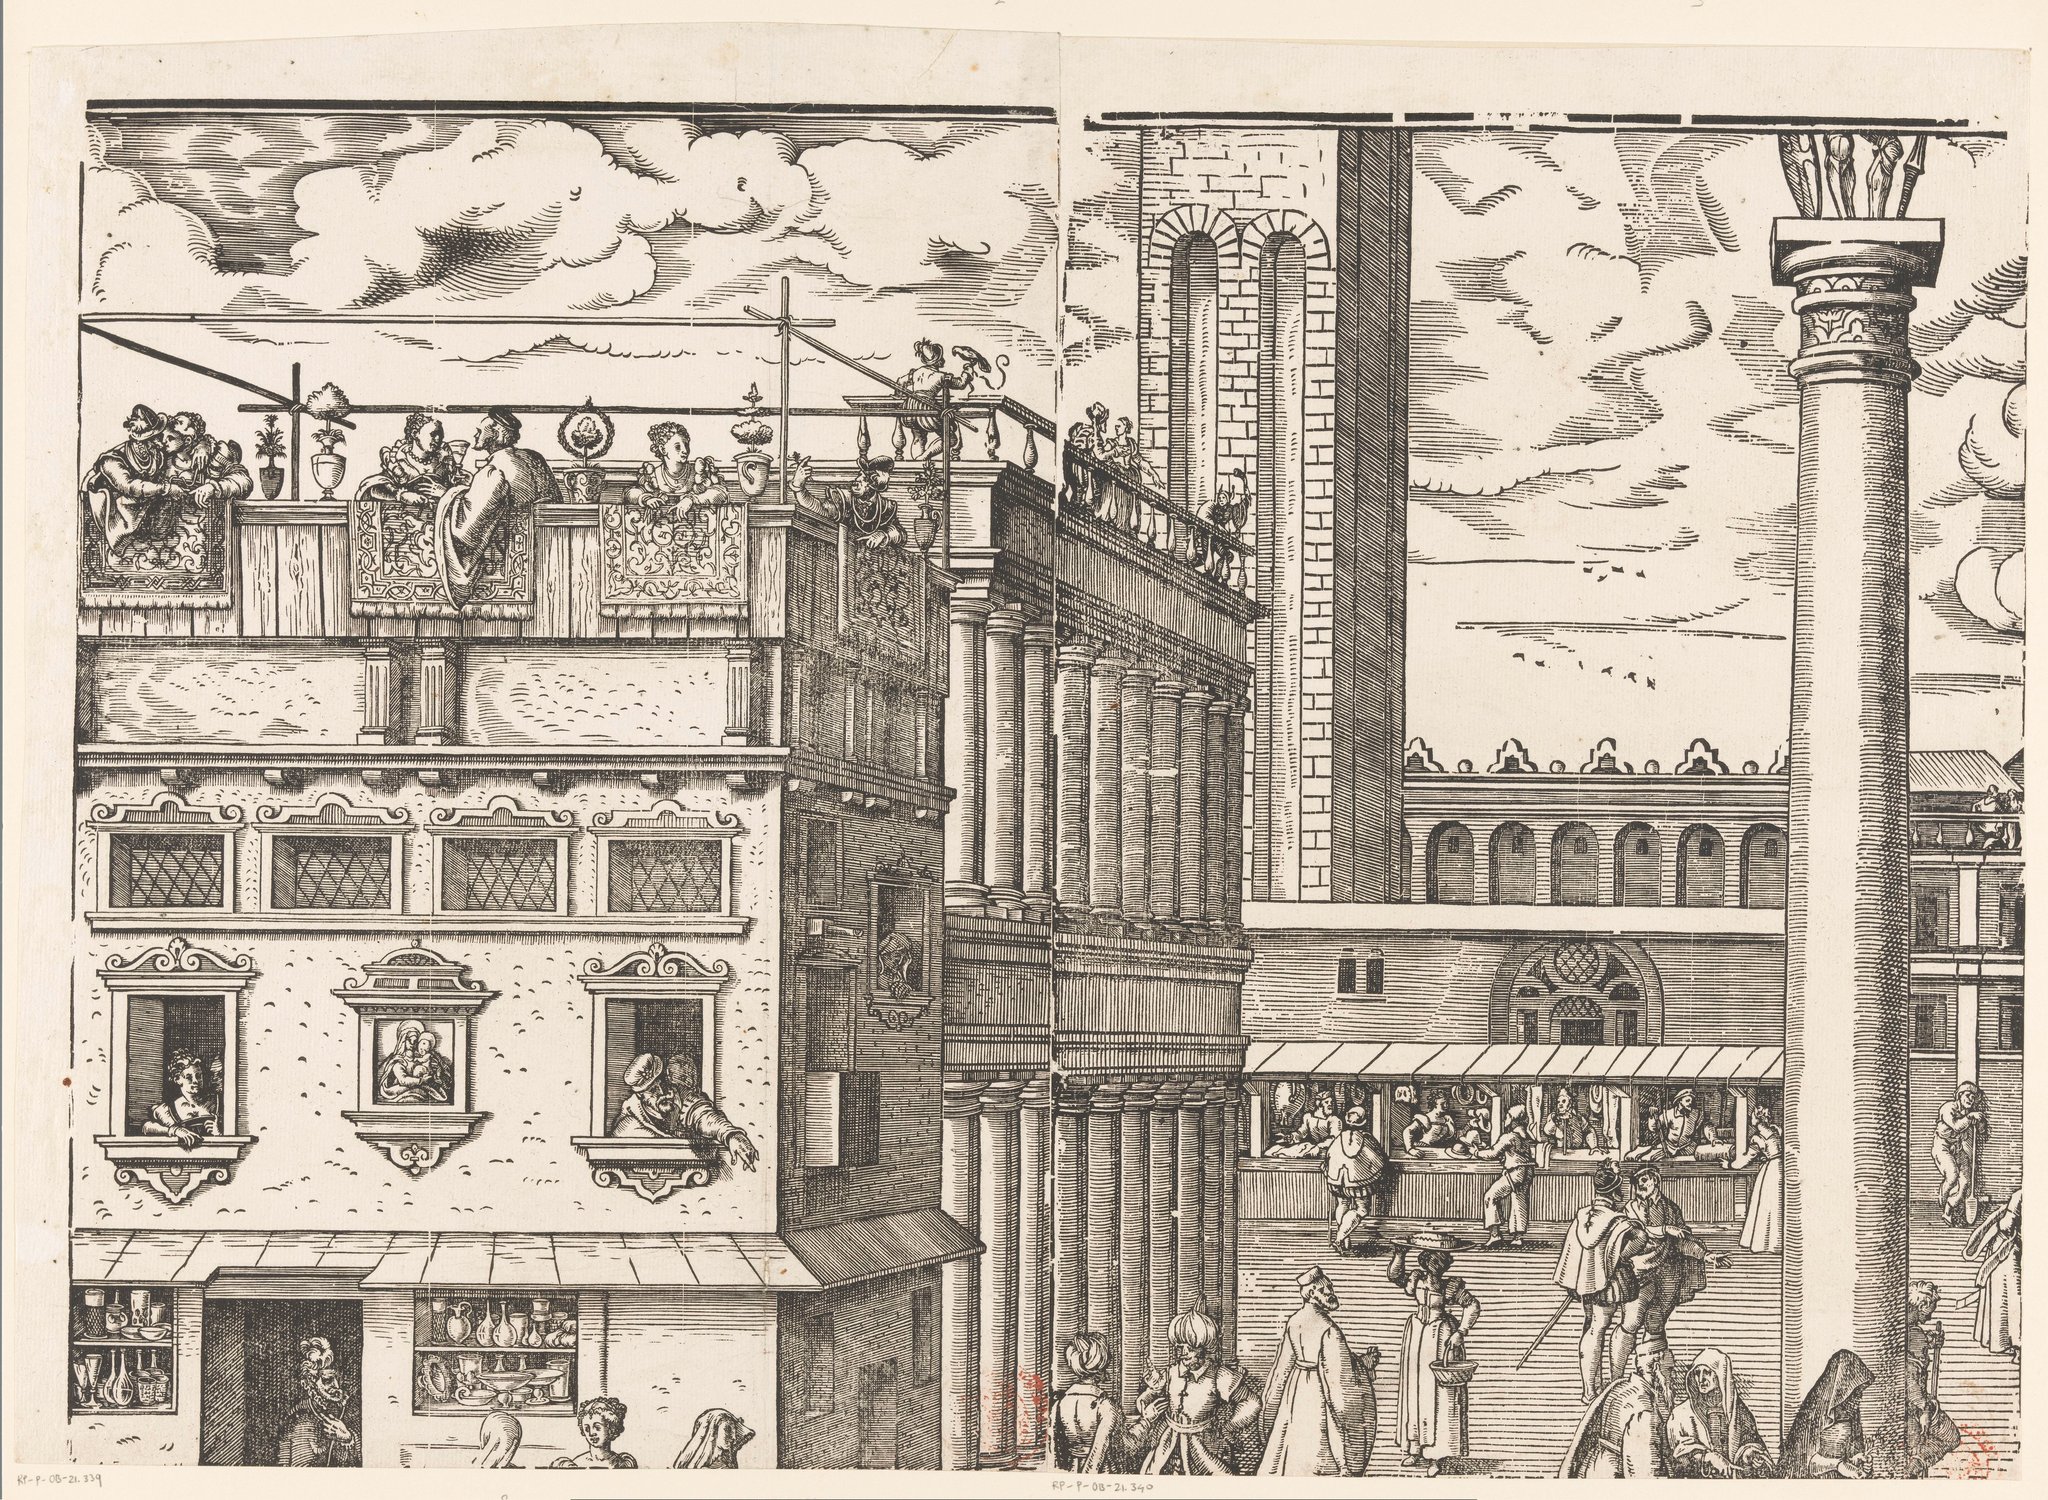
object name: print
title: Festa della Sensa (derde gedeelte)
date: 1679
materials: paper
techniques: woodcut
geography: nuremberg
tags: city-view in general; 'veduta', procession ~ christian religion, gondola, venice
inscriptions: collector's mark: Lugt 240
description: Derde gedeelte van een grote voorstelling van de Festa della Sensa. De voorstelling is gedrukt van veertien blokken, de titel van vijf blokken en het onderschrift bestaat uit vijf delen van elk drie kolommen Duits tekst. De veertien blokken die samen de voorstelling vormen zijn in de titels met de klok mee vanaf linksboven genummerd. In de collectie Rijksmuseum bevinden zich twee complete exemplaren inclusief titel en onderschrift. Omdat niet alle delen van de titel en het onderschrift op afzonderlijke bladen zijn gedrukt, is dit exemplaar niet virtueel samengevoegd omwille van een betere presentatie. Zie voor het andere exemplaar: RP-P-2017-6073.